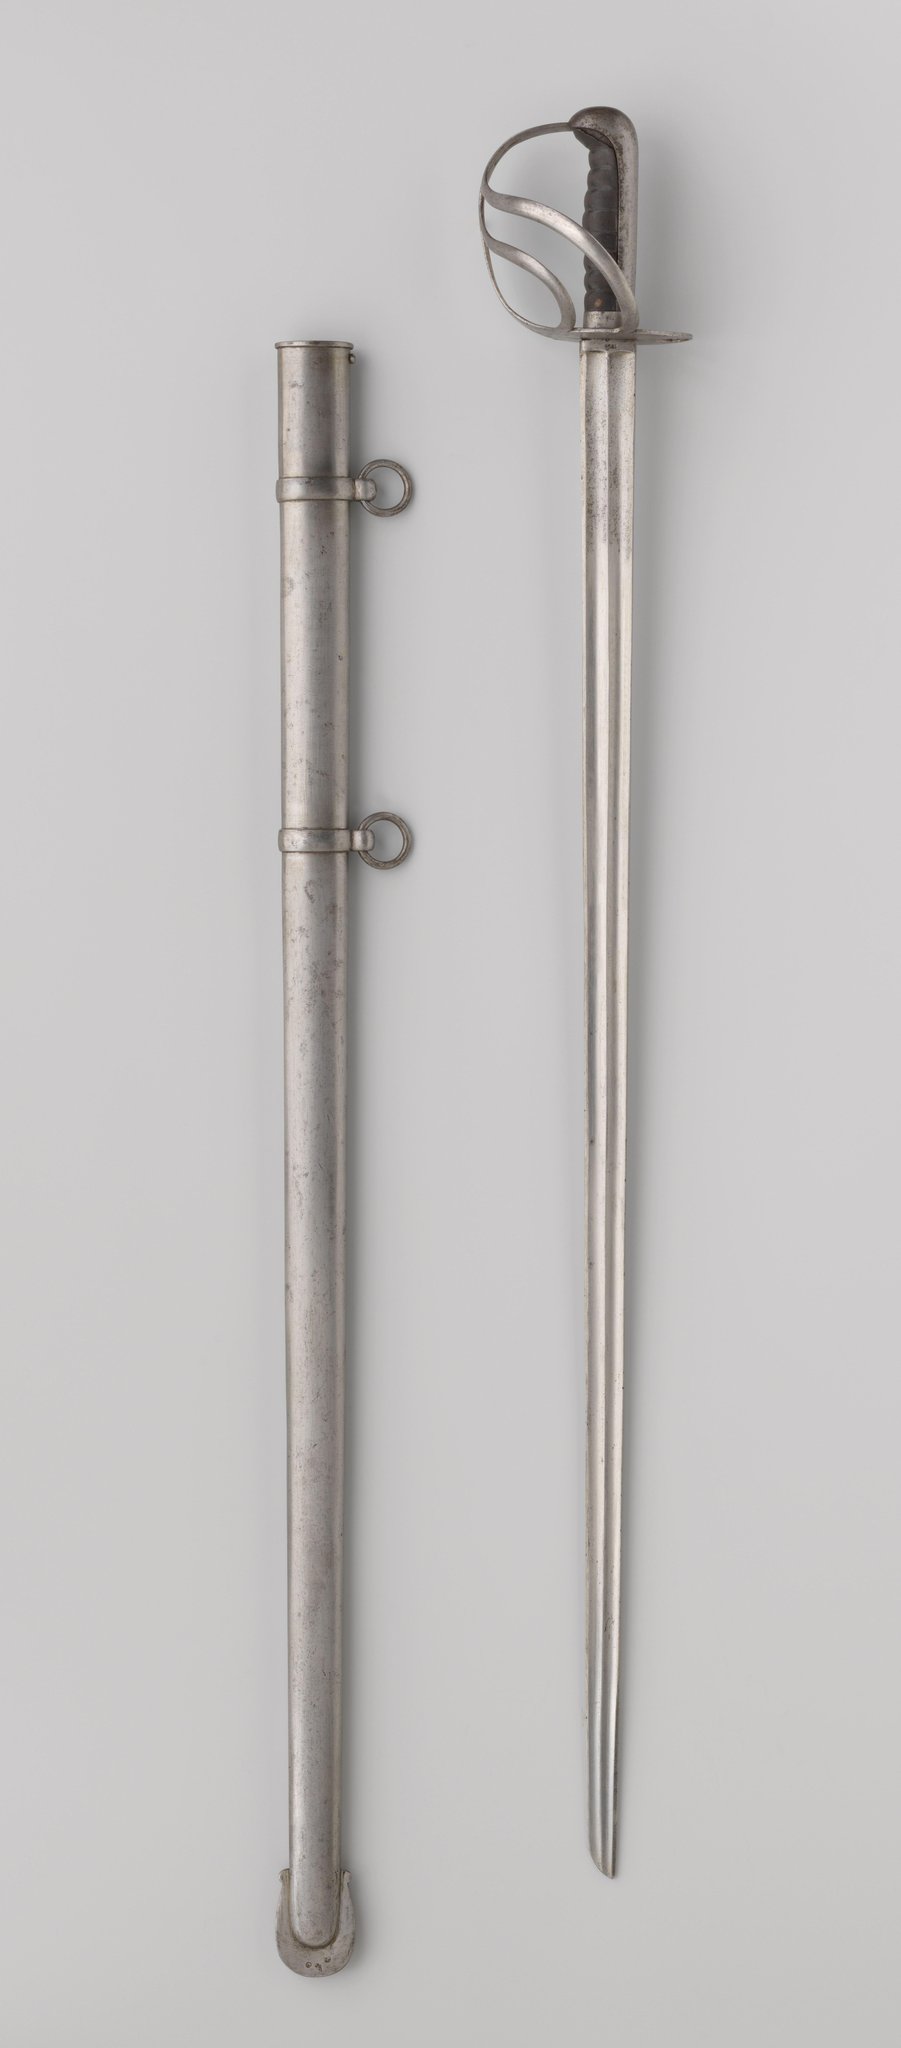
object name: sabre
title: Cavaleriesabel model nr. 7 dragonders, M 1844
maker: Anonymous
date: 1844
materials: iron, leather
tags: netherlands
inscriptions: date: ‘1826’, number: ‘206’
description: Sabel cavalerie model nr. 7, 1844, 1 D 89, dragonders voor karabijn, als nr. 229.